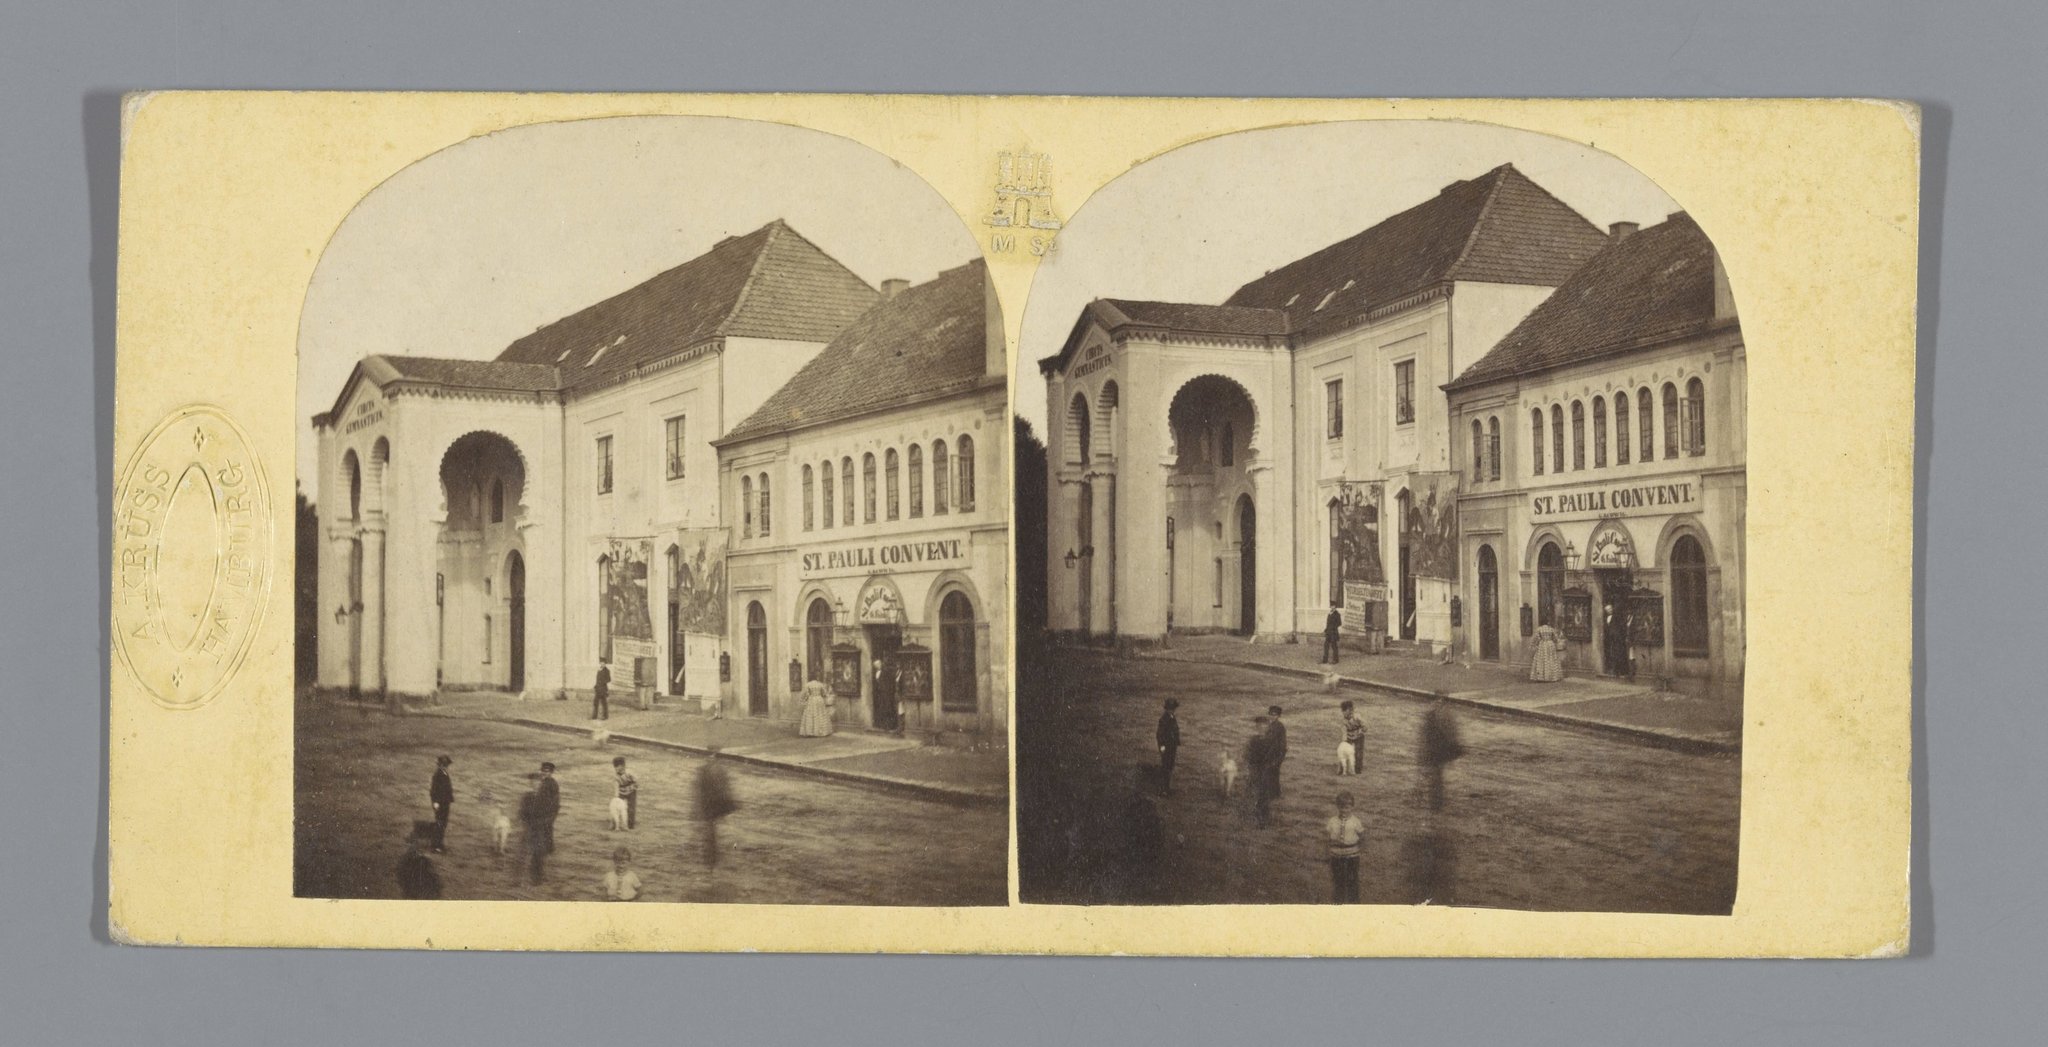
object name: stereograph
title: Exterieur van het Circus Gymnasticus te Hamburg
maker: a. krüss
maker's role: manufacturer, publisher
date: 1855-1880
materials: cardboard, photographic support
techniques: albumen print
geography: hamburg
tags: abbey, monastery, convent ~ roman catholic church, theatre (building), façade (of house or building)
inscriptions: number: ‘47’, inscription: ‘Hamburg Circus Gymnasticus & St Pauli Convent’, name: ‘A. Krüss Hamburg’